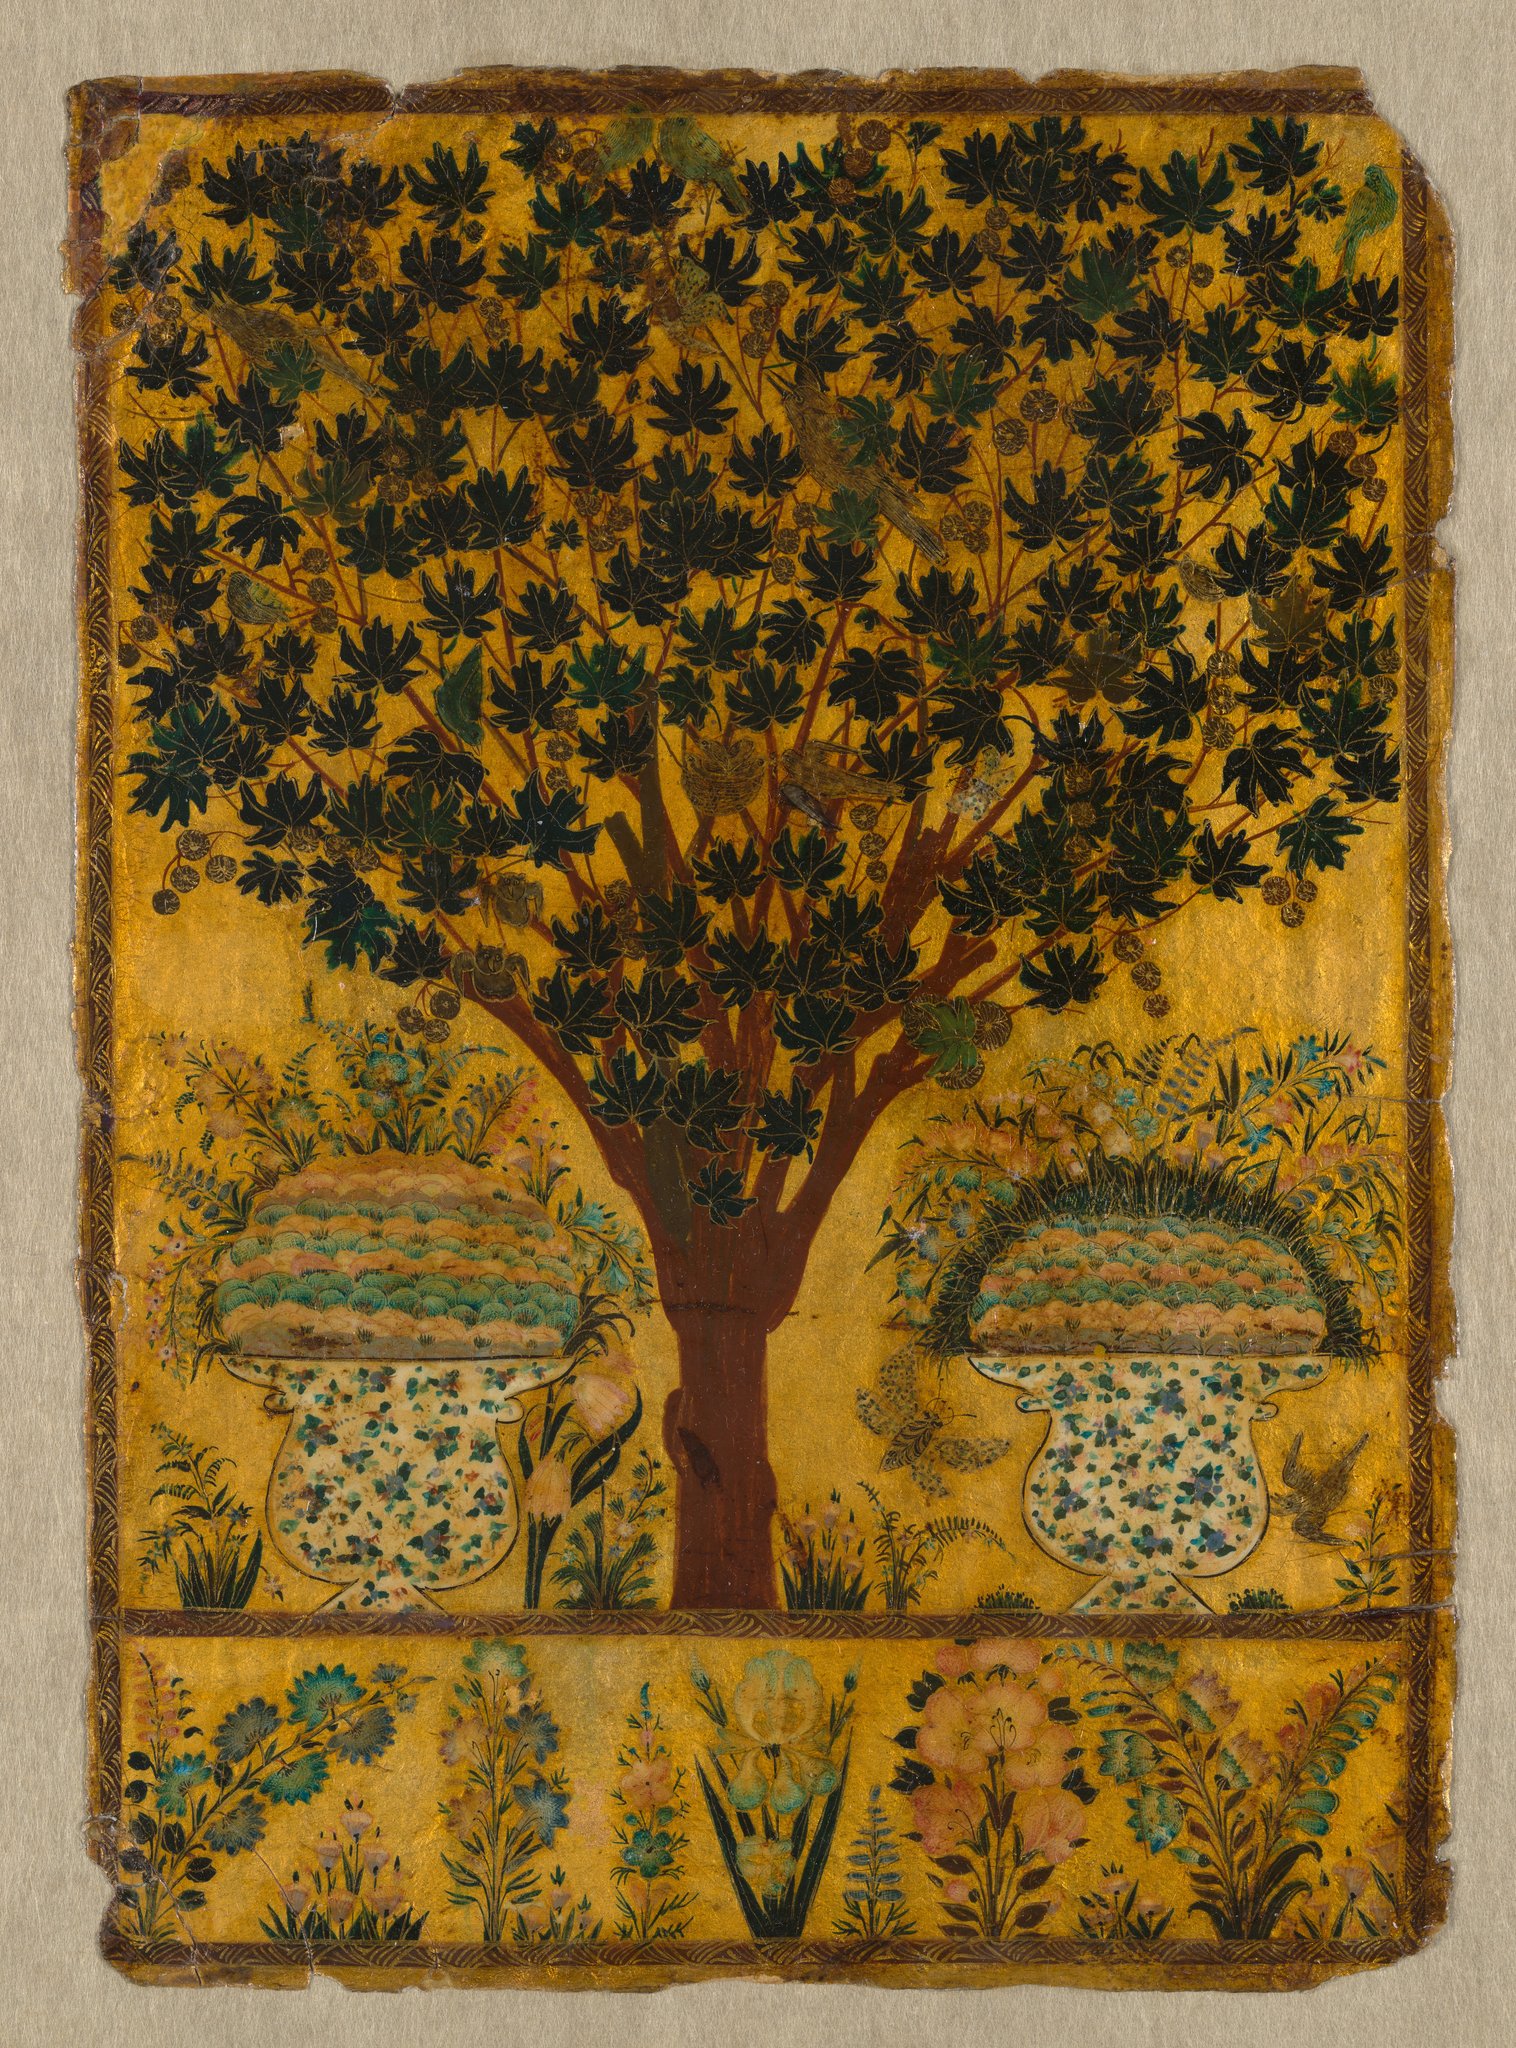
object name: book cover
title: Book Cover with Tree, Birds, and Insects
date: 1700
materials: gold, lacquer, leather, watercolor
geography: india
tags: trees